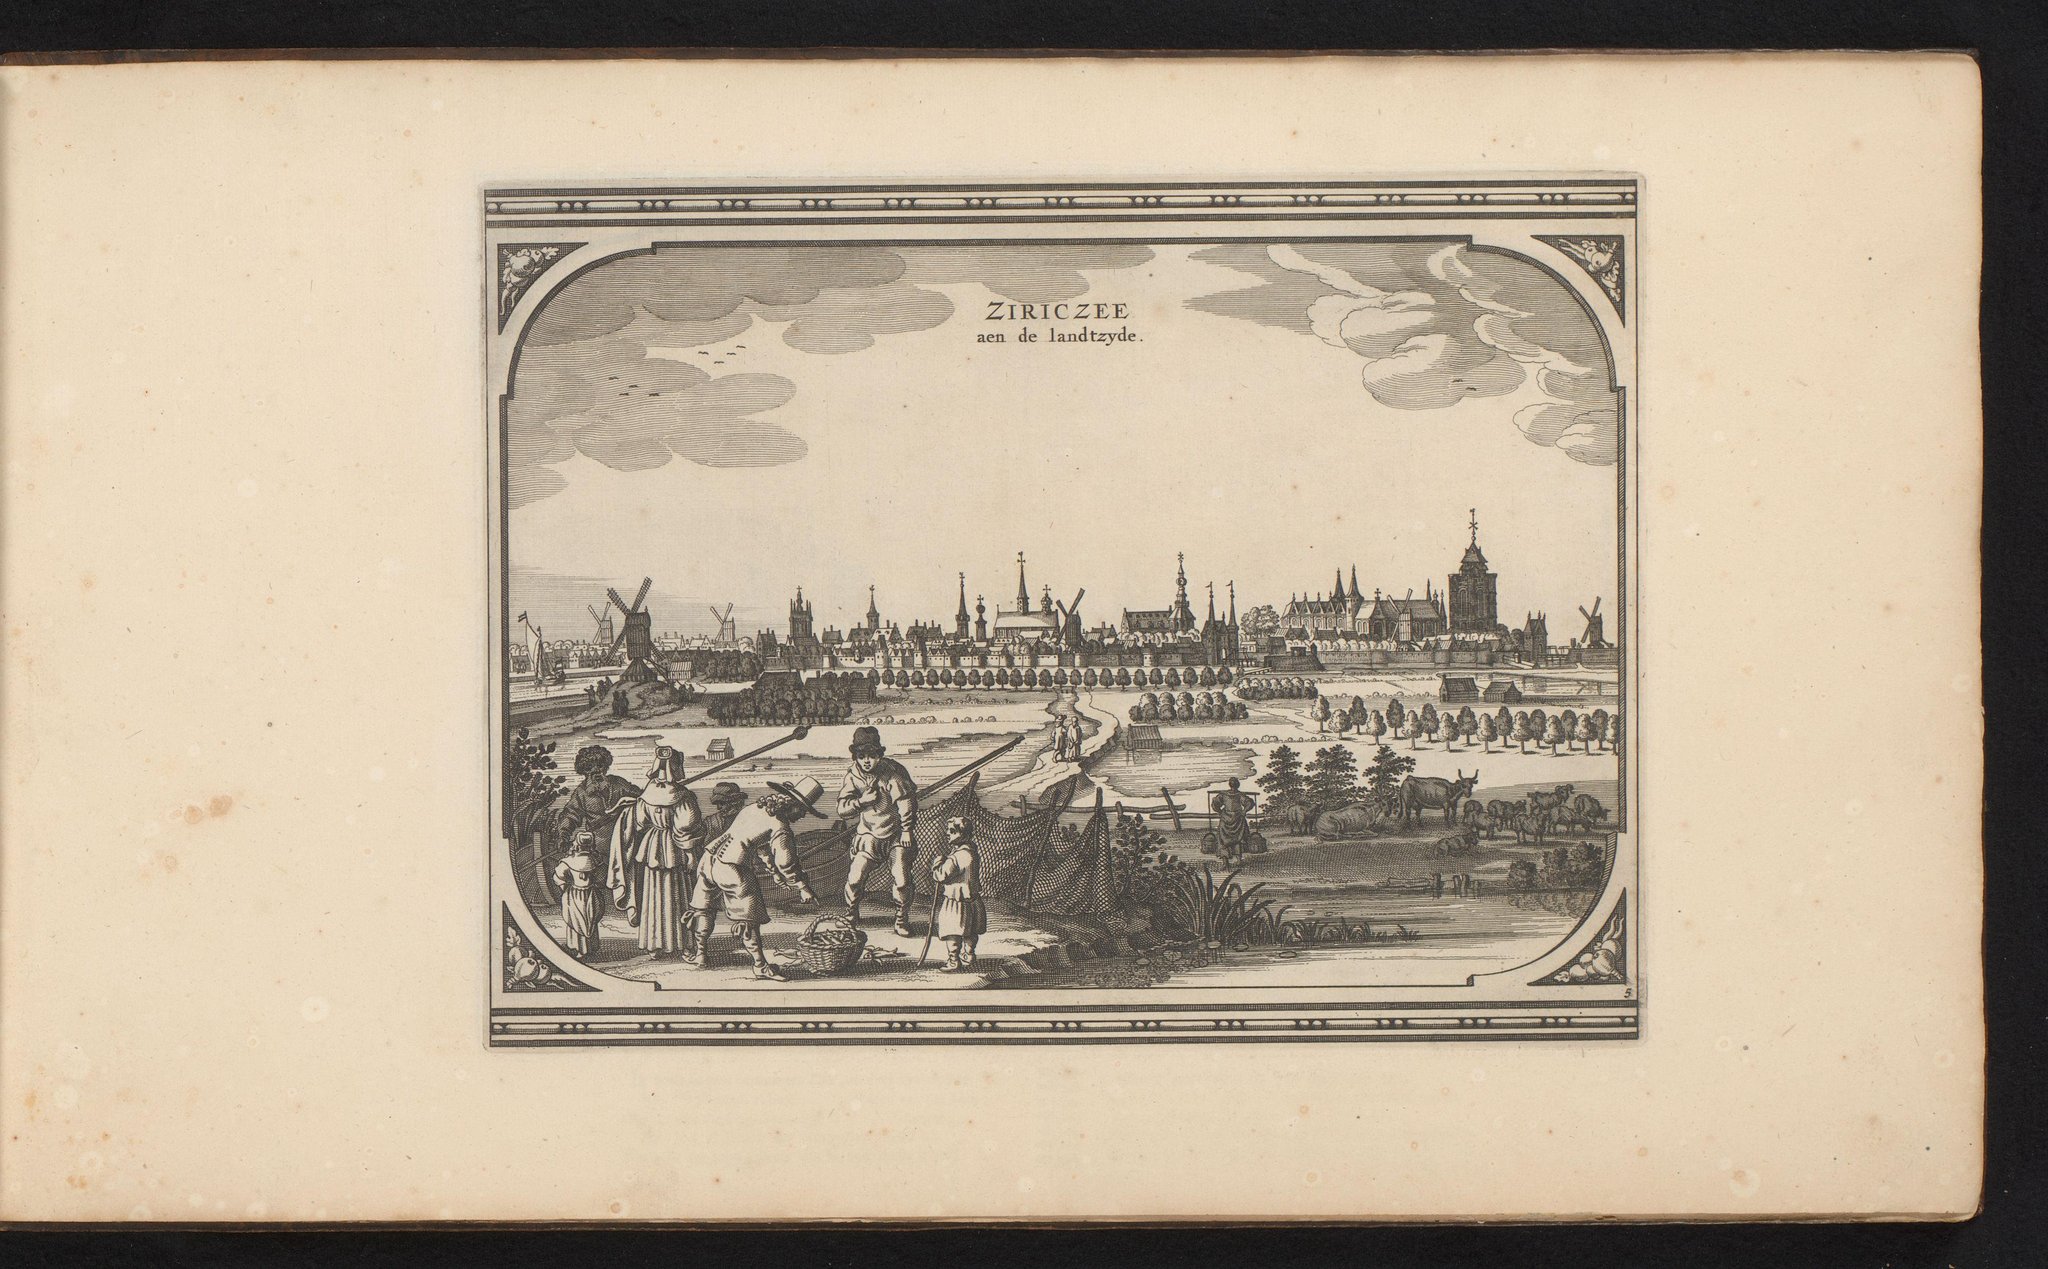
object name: album leaf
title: Speculum Zelandiae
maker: pieter hendricksz. schut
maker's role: print maker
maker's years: 1618-1660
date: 1662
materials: paper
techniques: etching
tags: city-view, and landscape with man-made constructions, yoke, fisherman, buying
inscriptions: collector's mark: Lugt 195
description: Gezicht op de stad Zierikzee. Op de voorgrond staat een welgestelde familie bij enkele vissers. De heer wijst naar de mand met vissen op de grond. Verderop loopt een vrouw met een juk. De prent maakt deel uit van een album.